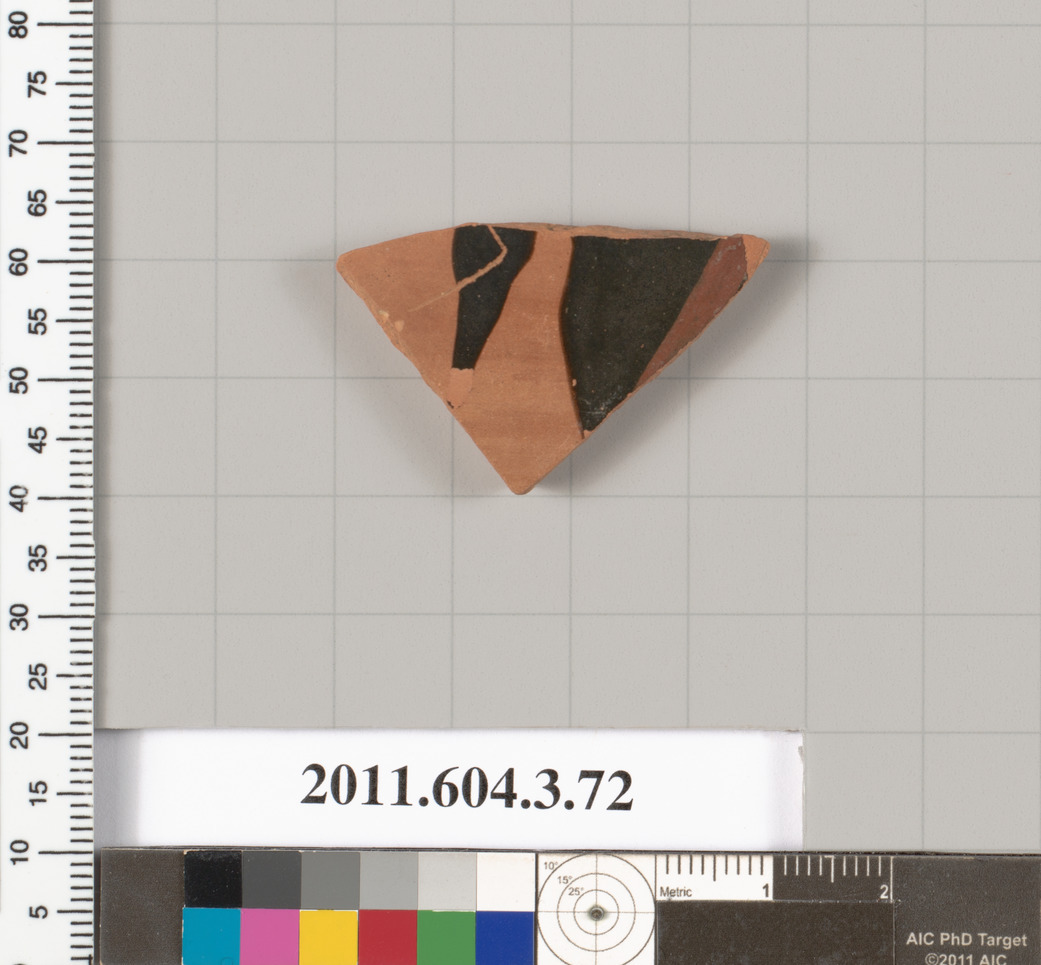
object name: amphora fragment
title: Terracotta fragment of an amphora (jar)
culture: greek, attic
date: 525-501 BCE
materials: terracotta